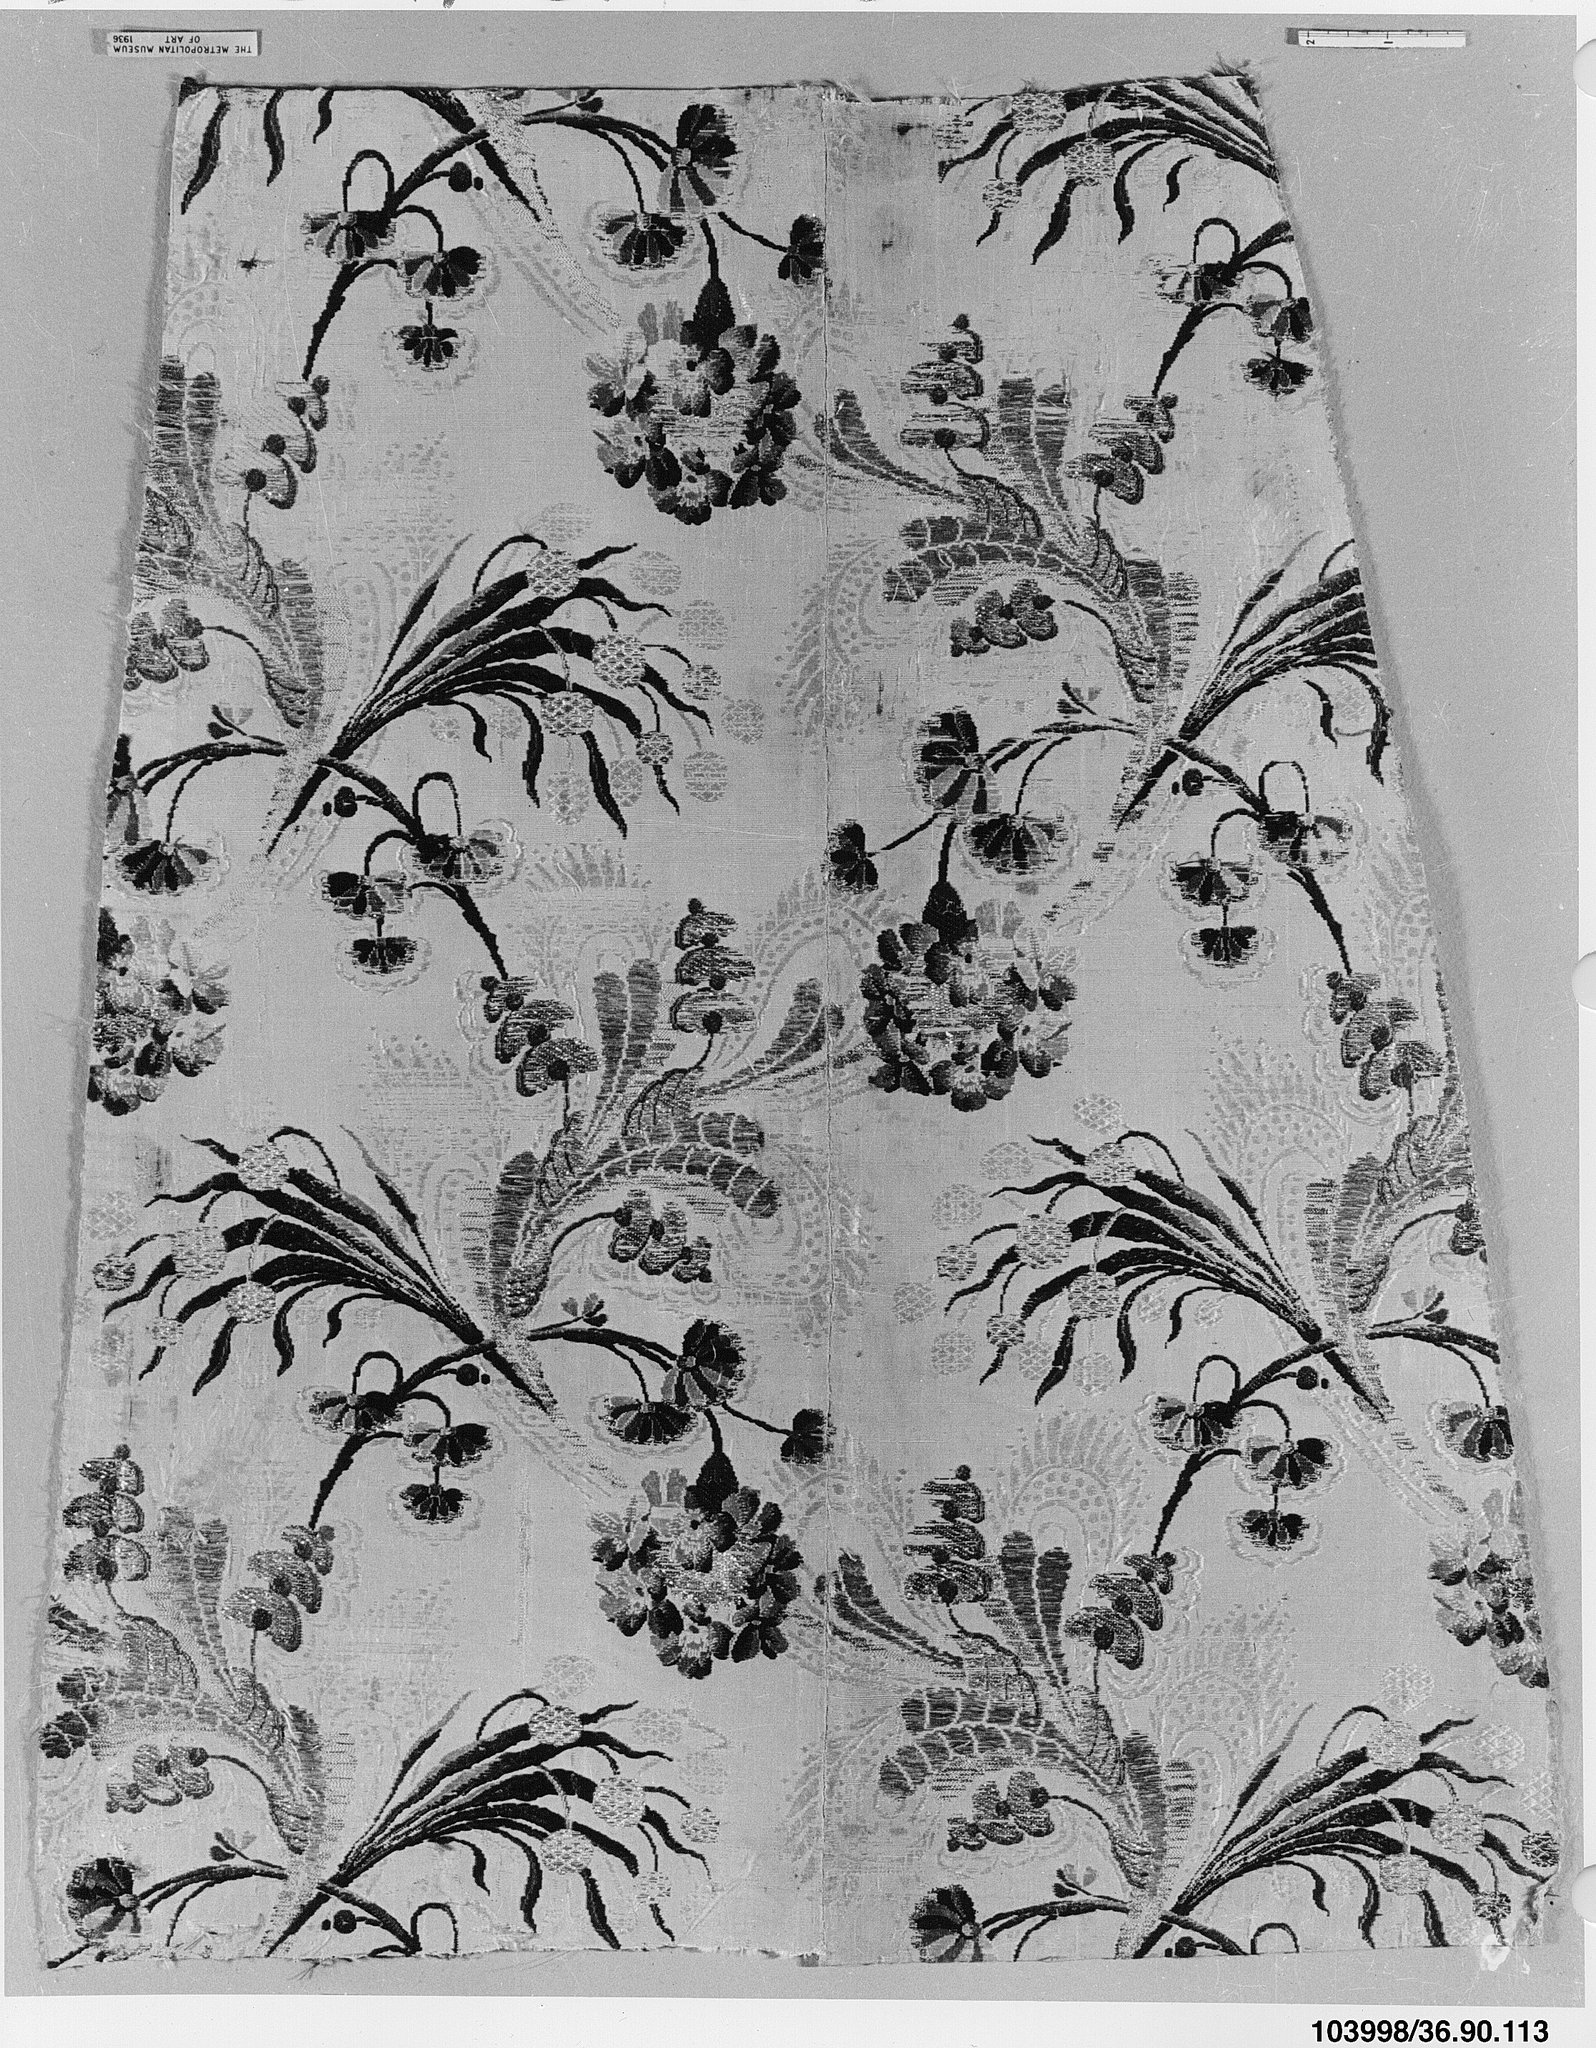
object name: piece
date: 1750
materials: metal thread, silk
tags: flowers,leaves